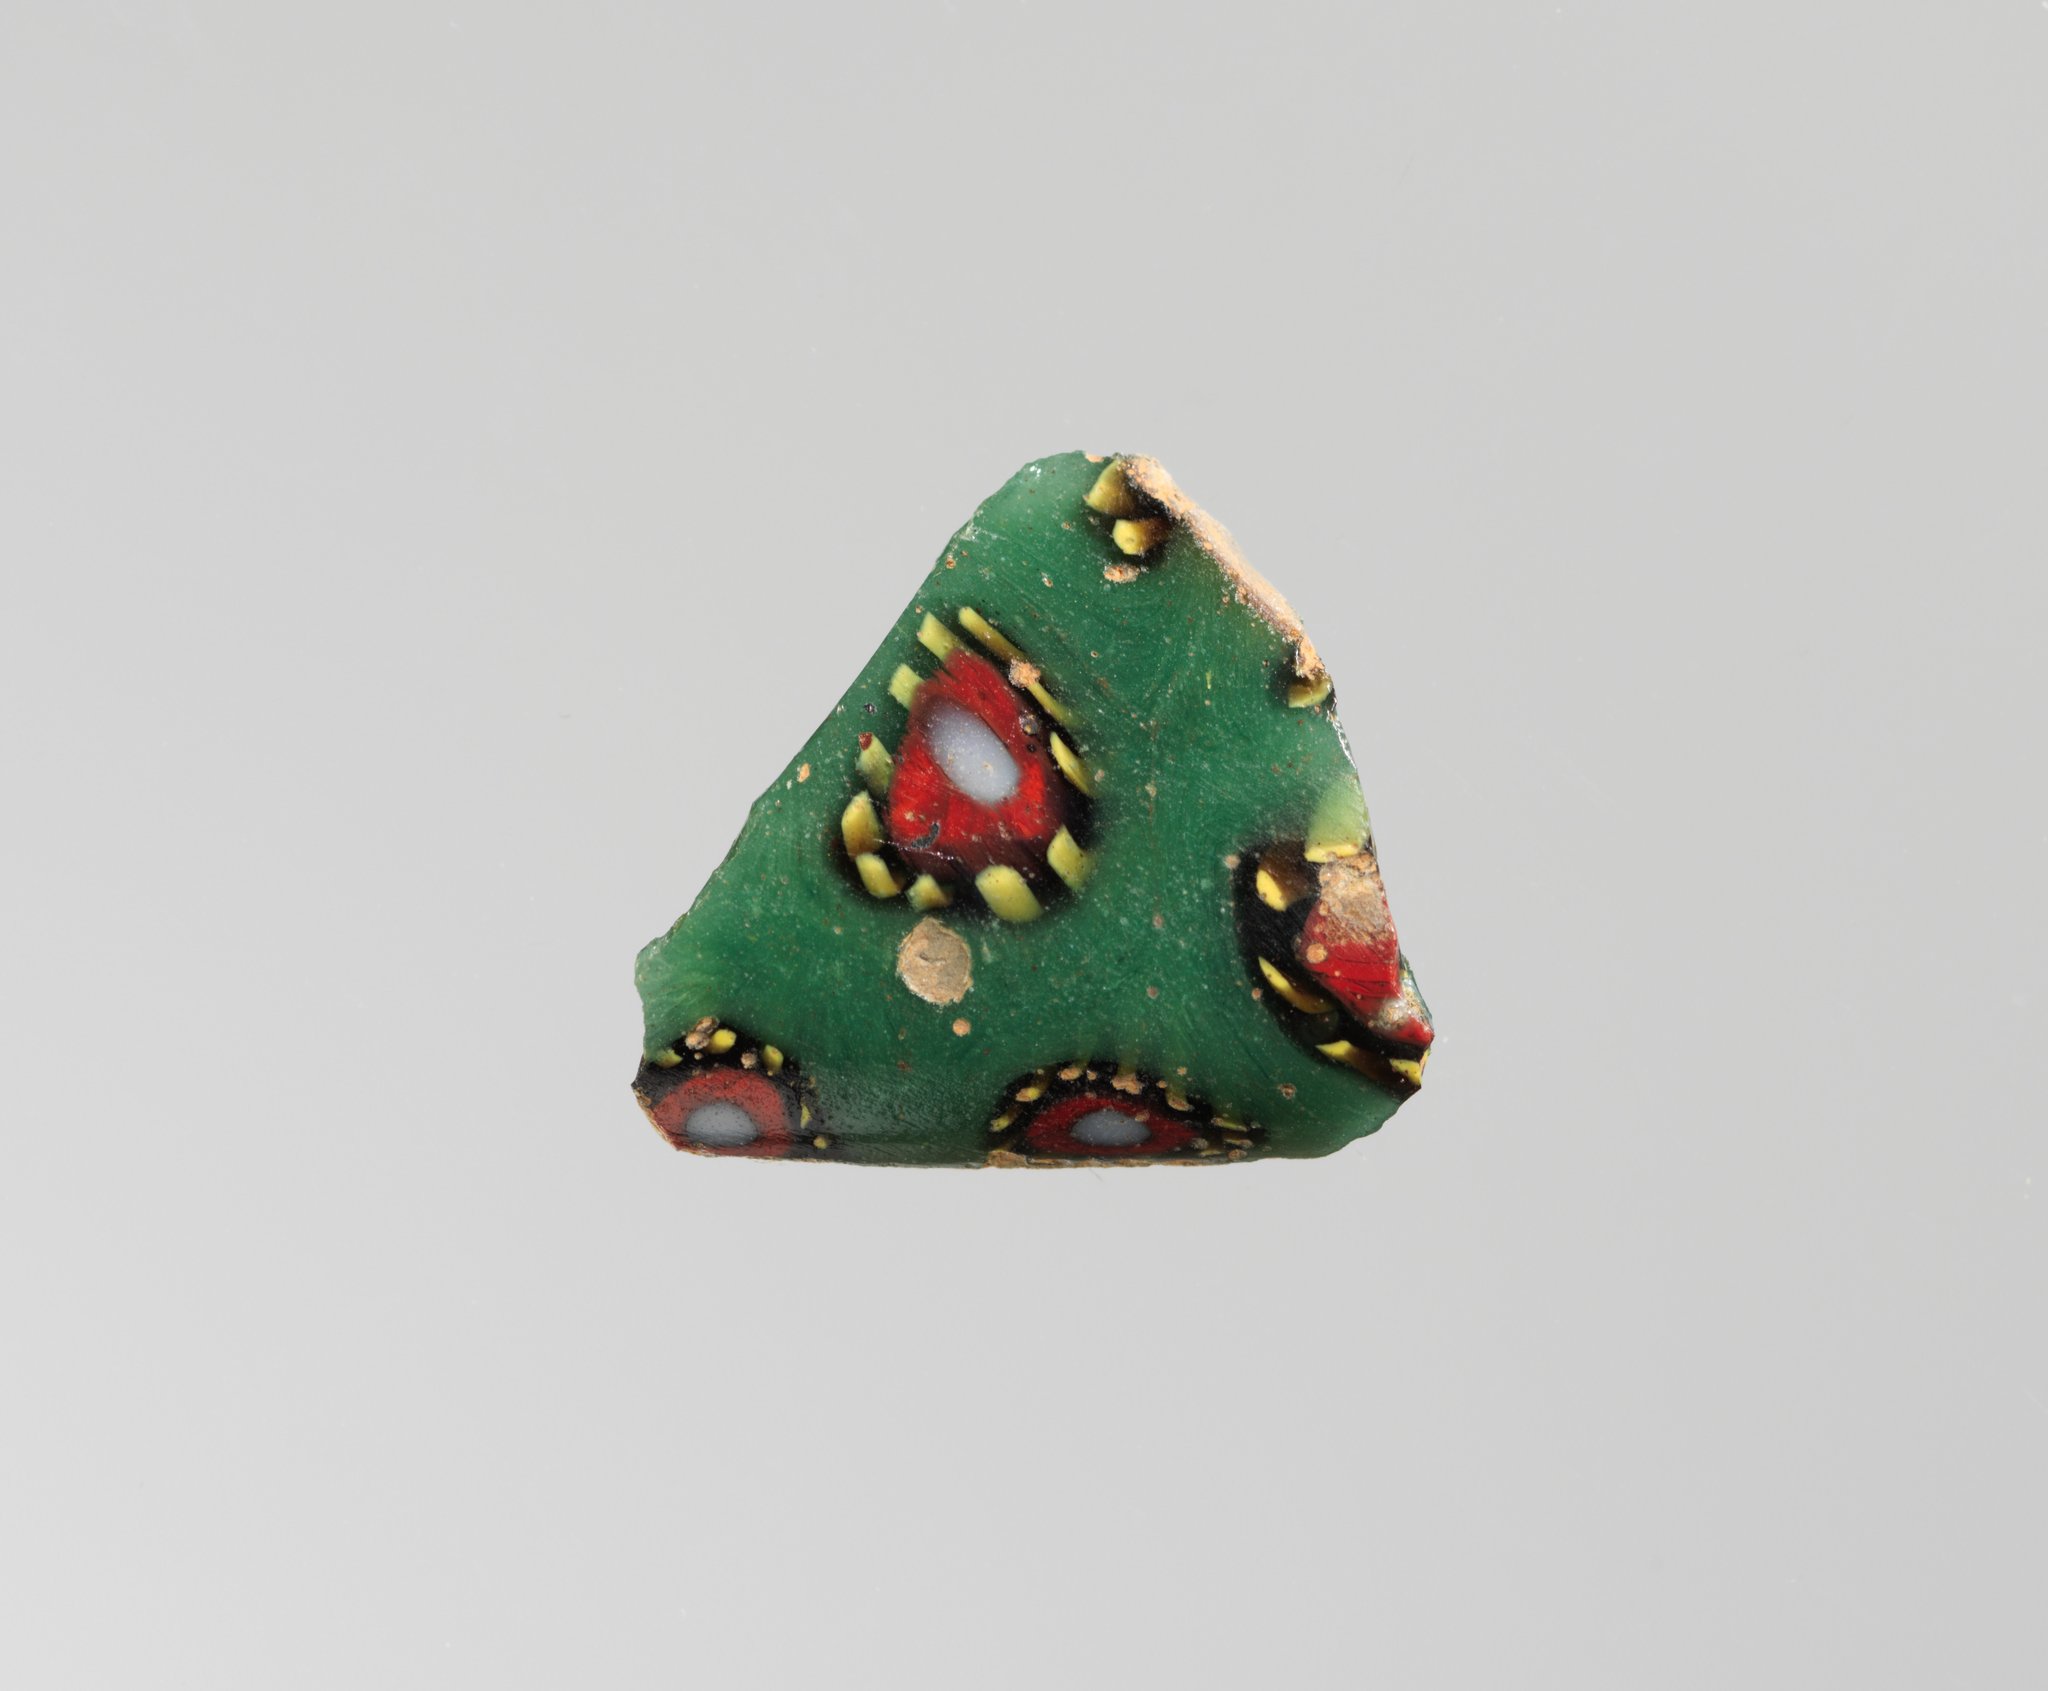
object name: fragment, mosaic bowl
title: Glass mosaic bowl fragment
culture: roman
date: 34 BCE-33 CE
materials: glass